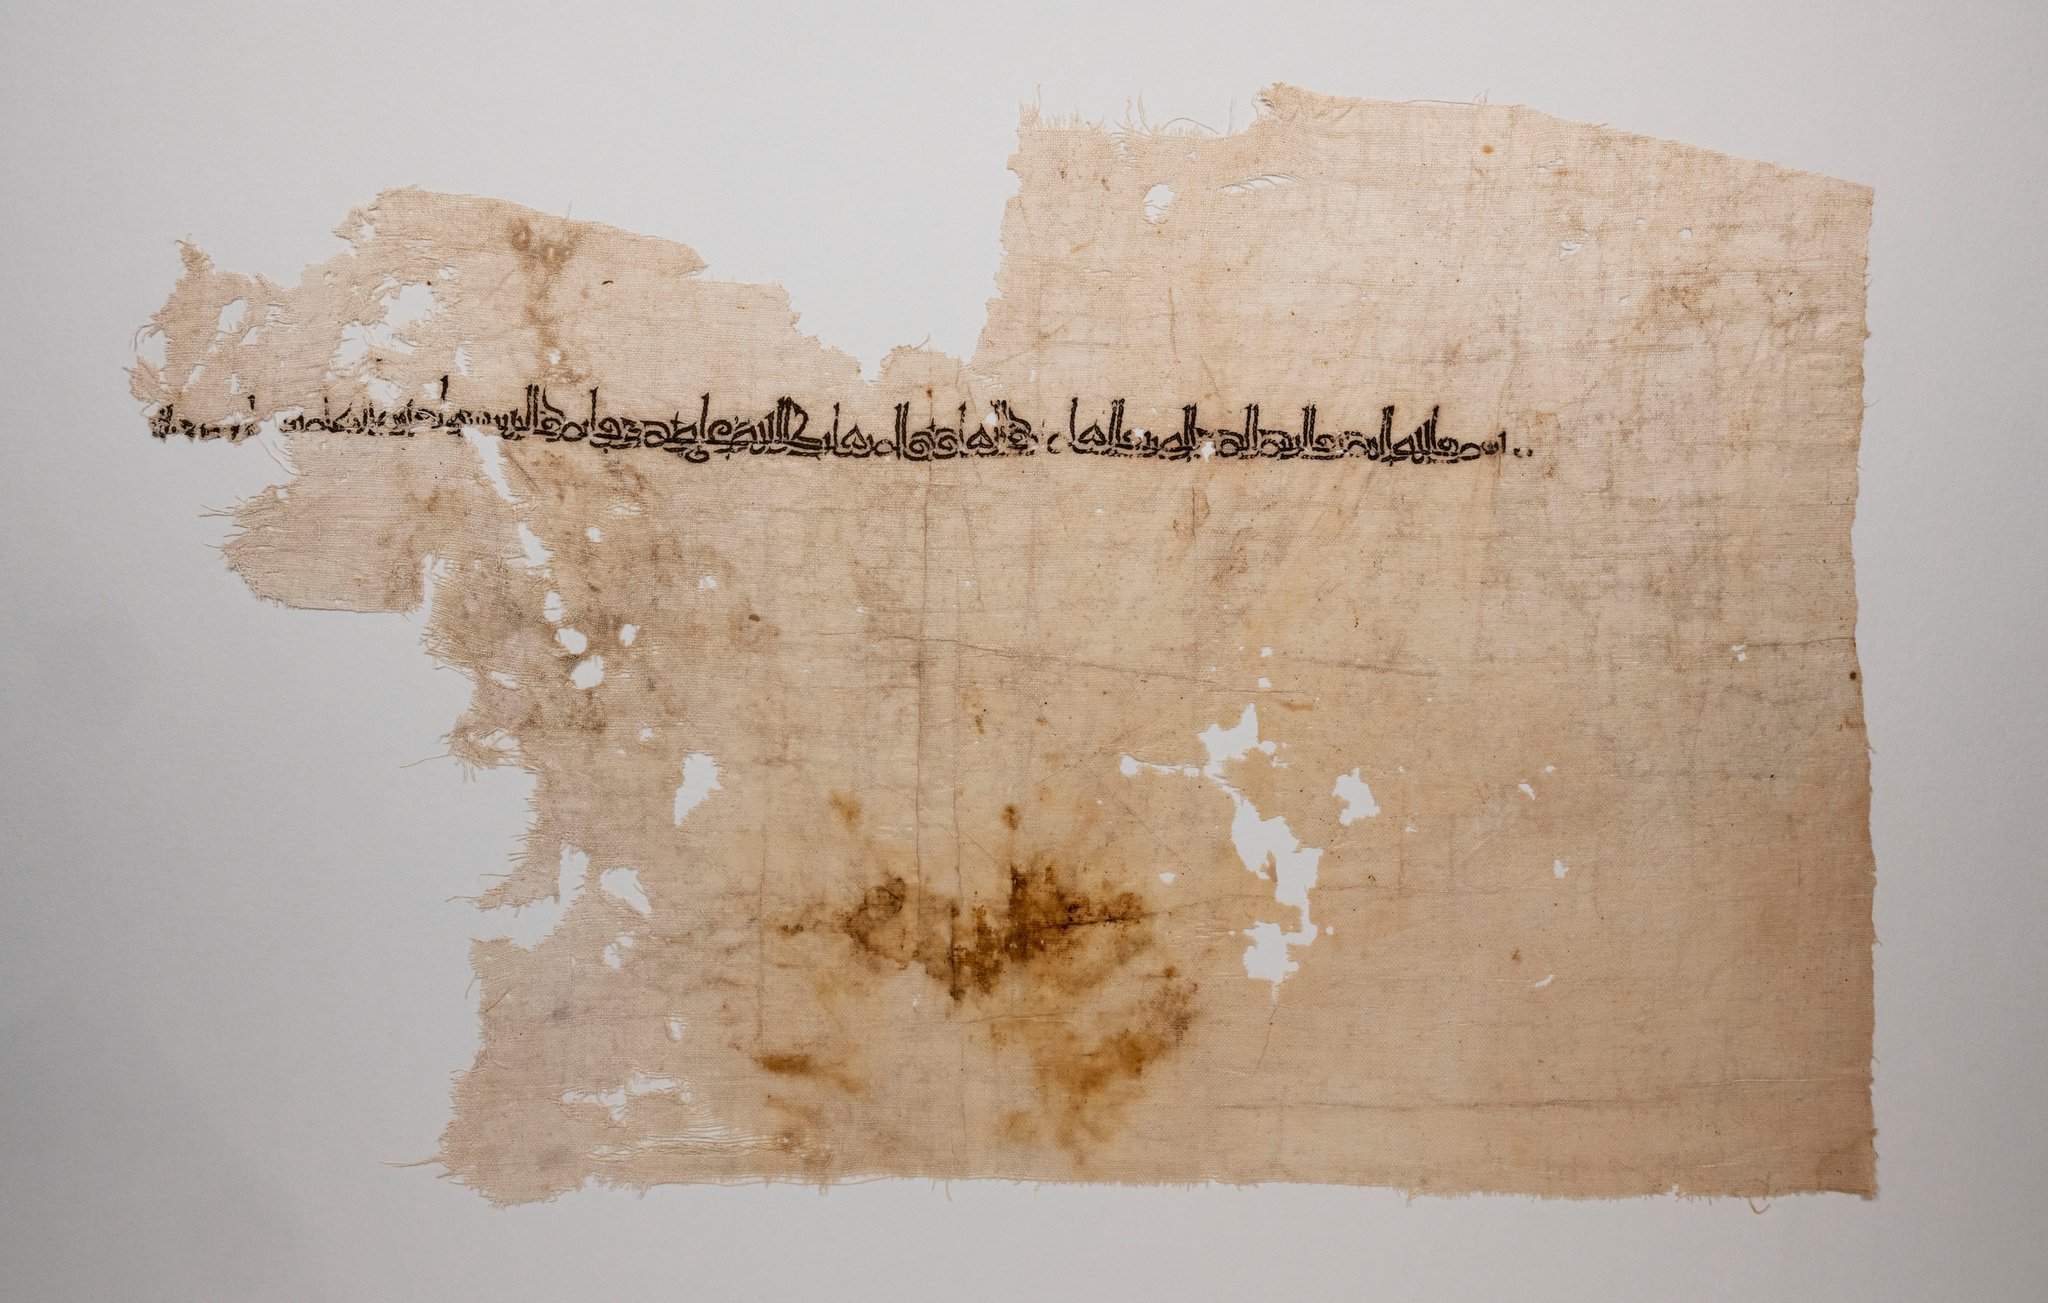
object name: textile fragment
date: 901-1000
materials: linen, silk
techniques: embroidery, weave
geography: egypt